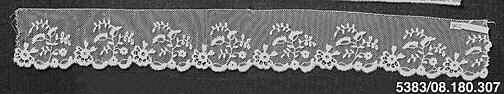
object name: collar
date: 1767-1800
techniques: lace